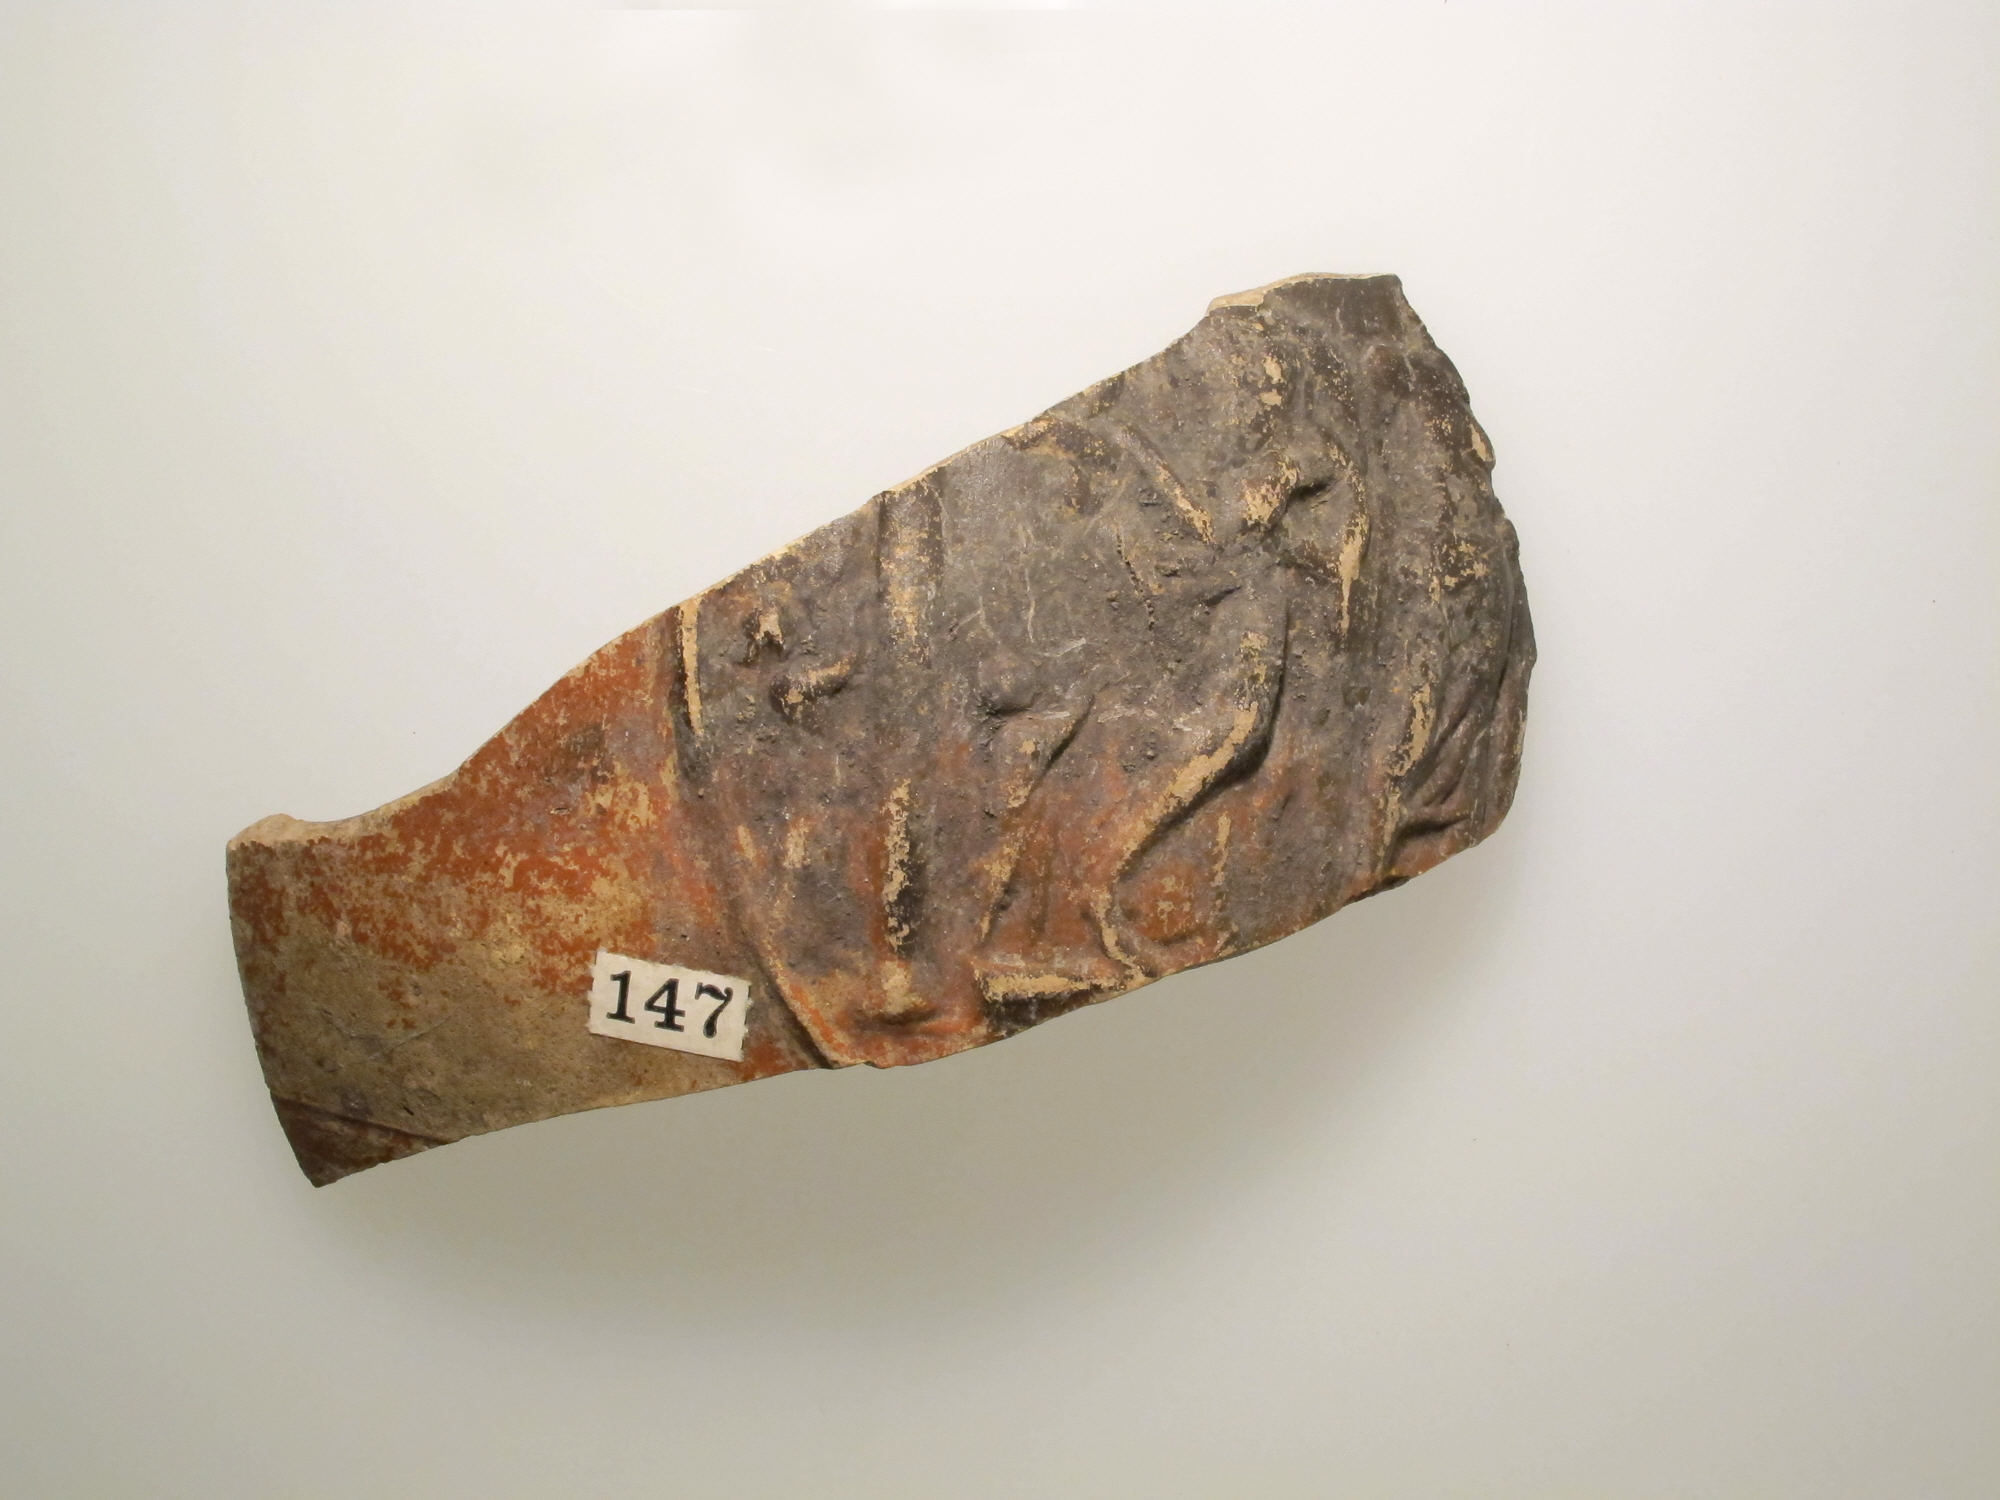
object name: vase fragment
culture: roman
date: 101-150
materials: terracotta